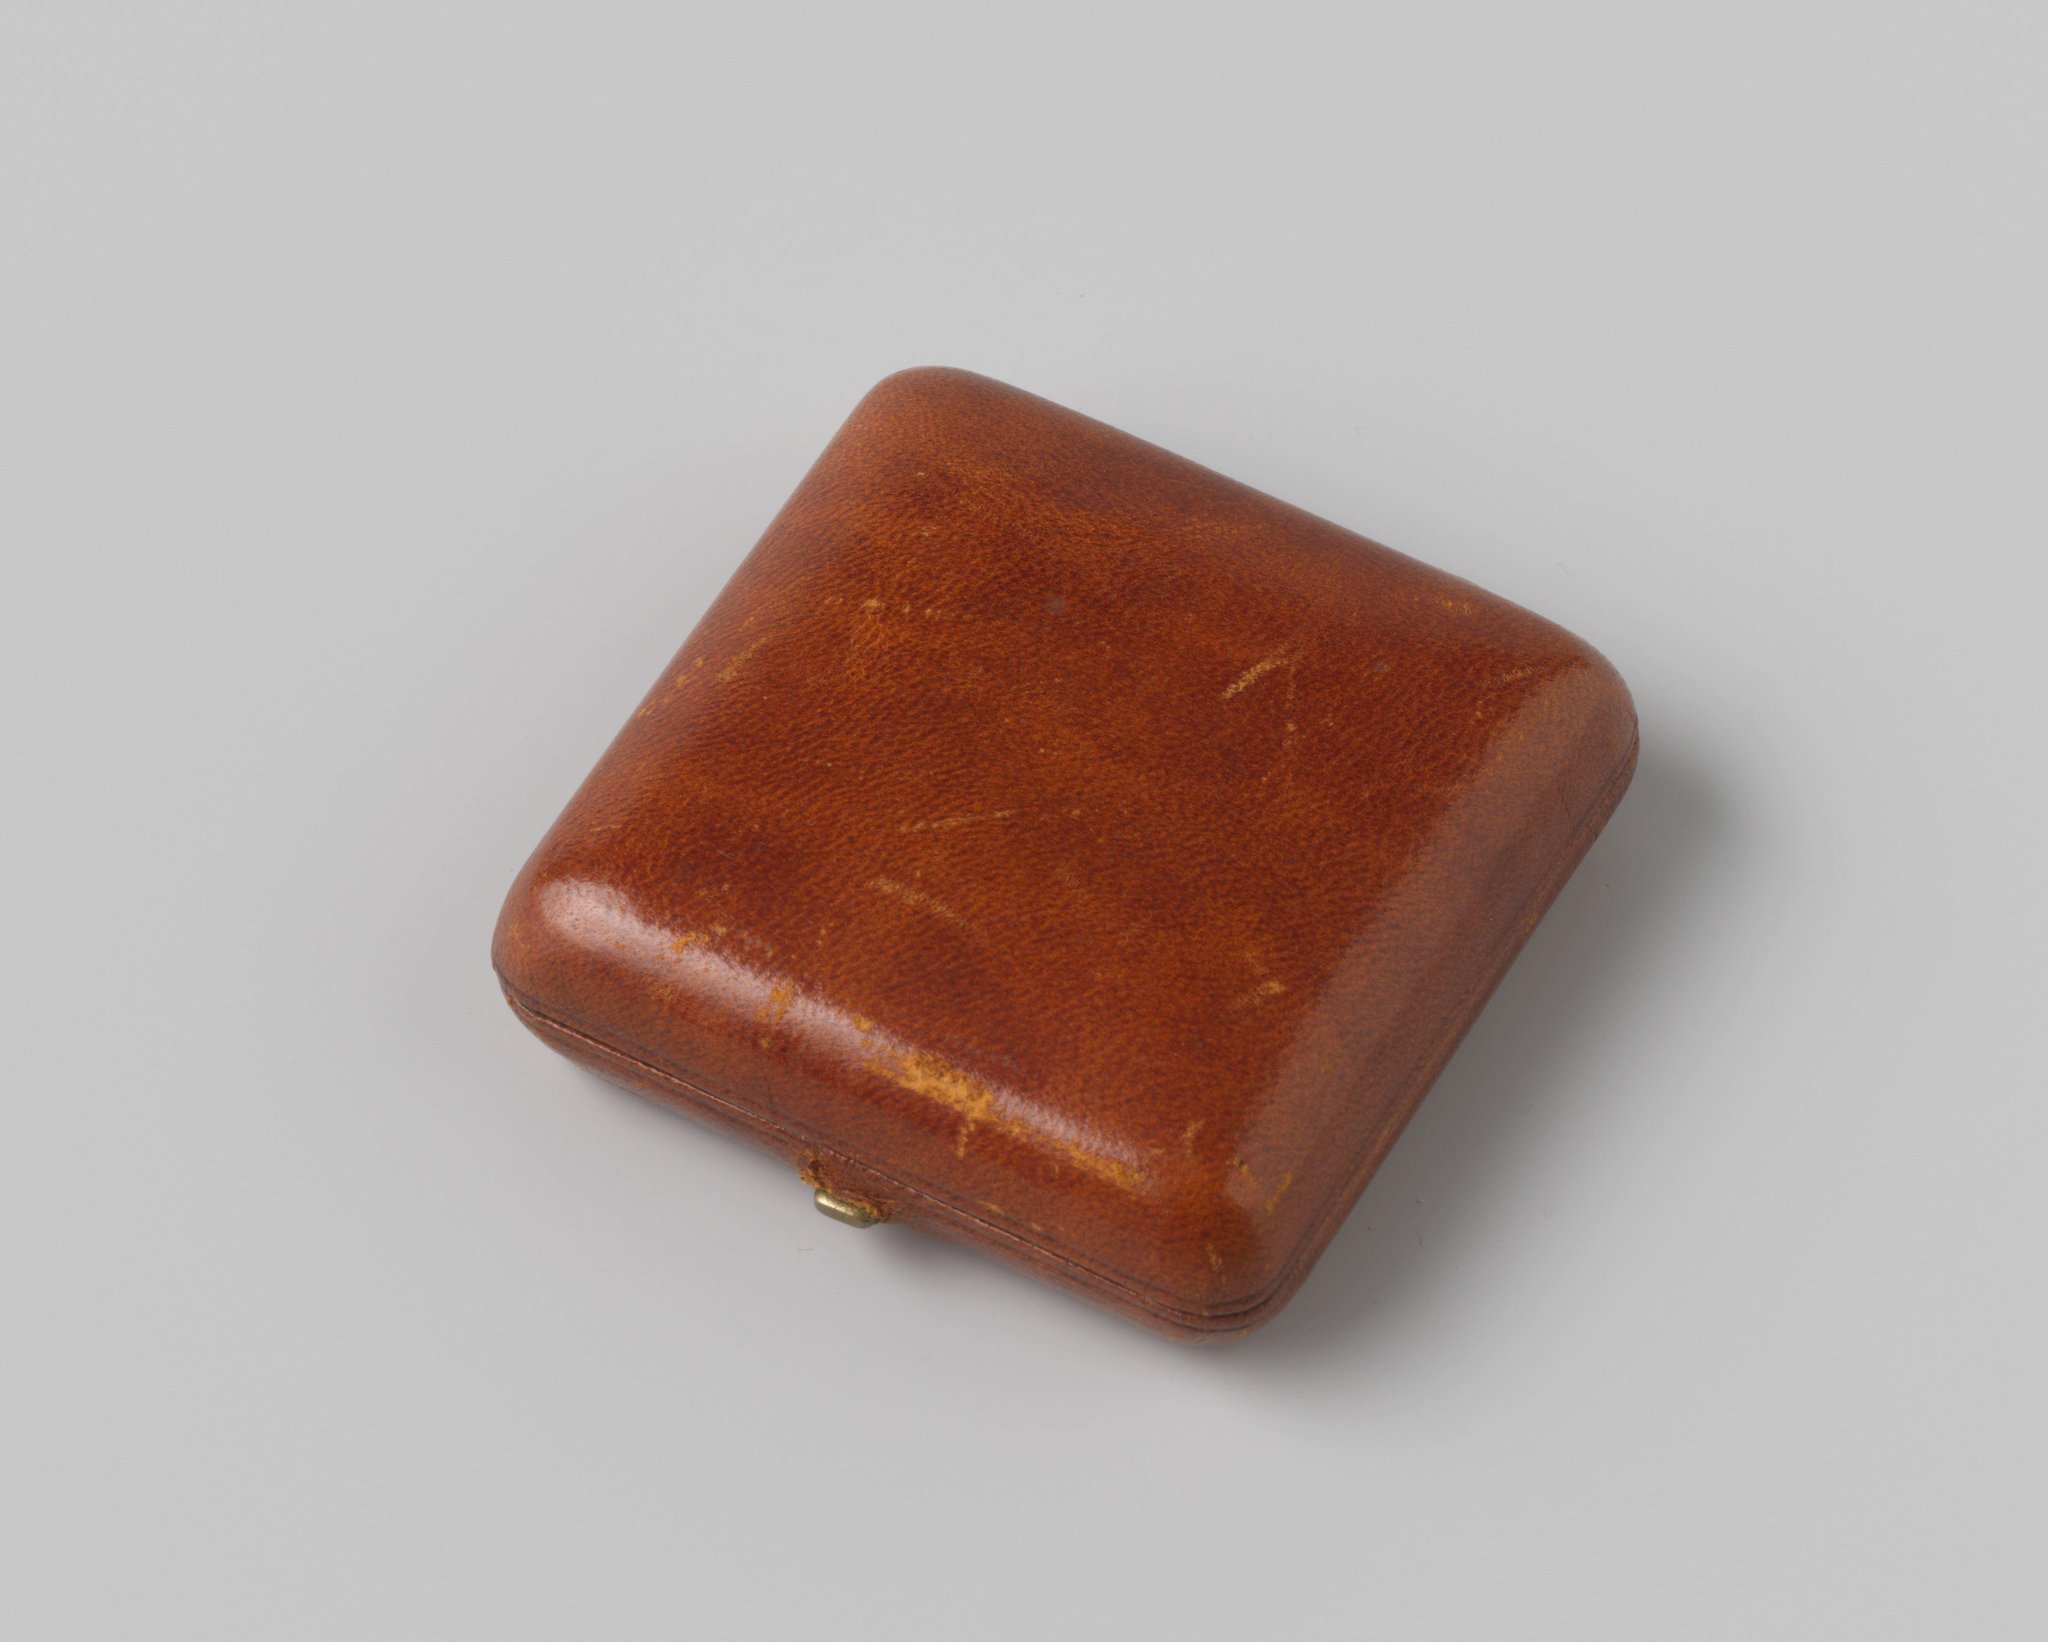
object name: medal box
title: Penningdoosje voor de penning ter gelegenheid van de kerstvlucht van de Pelikaan van Nederland naar Nederlandsch-Indië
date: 1933-1940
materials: copper, leather, textile, velvet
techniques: pressing, sewing, weave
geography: le locle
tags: netherlands, dutch east indies, the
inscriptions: inscription: ‘Huguenin Médailleurs Le Locle’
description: Penningdoosje, aan de binnenzijde in de deksel met wit satijn bespannen en in de doos met velours een ronde uitsparing voor een penning of munt. Het doosje heeft een koperen sluiting.